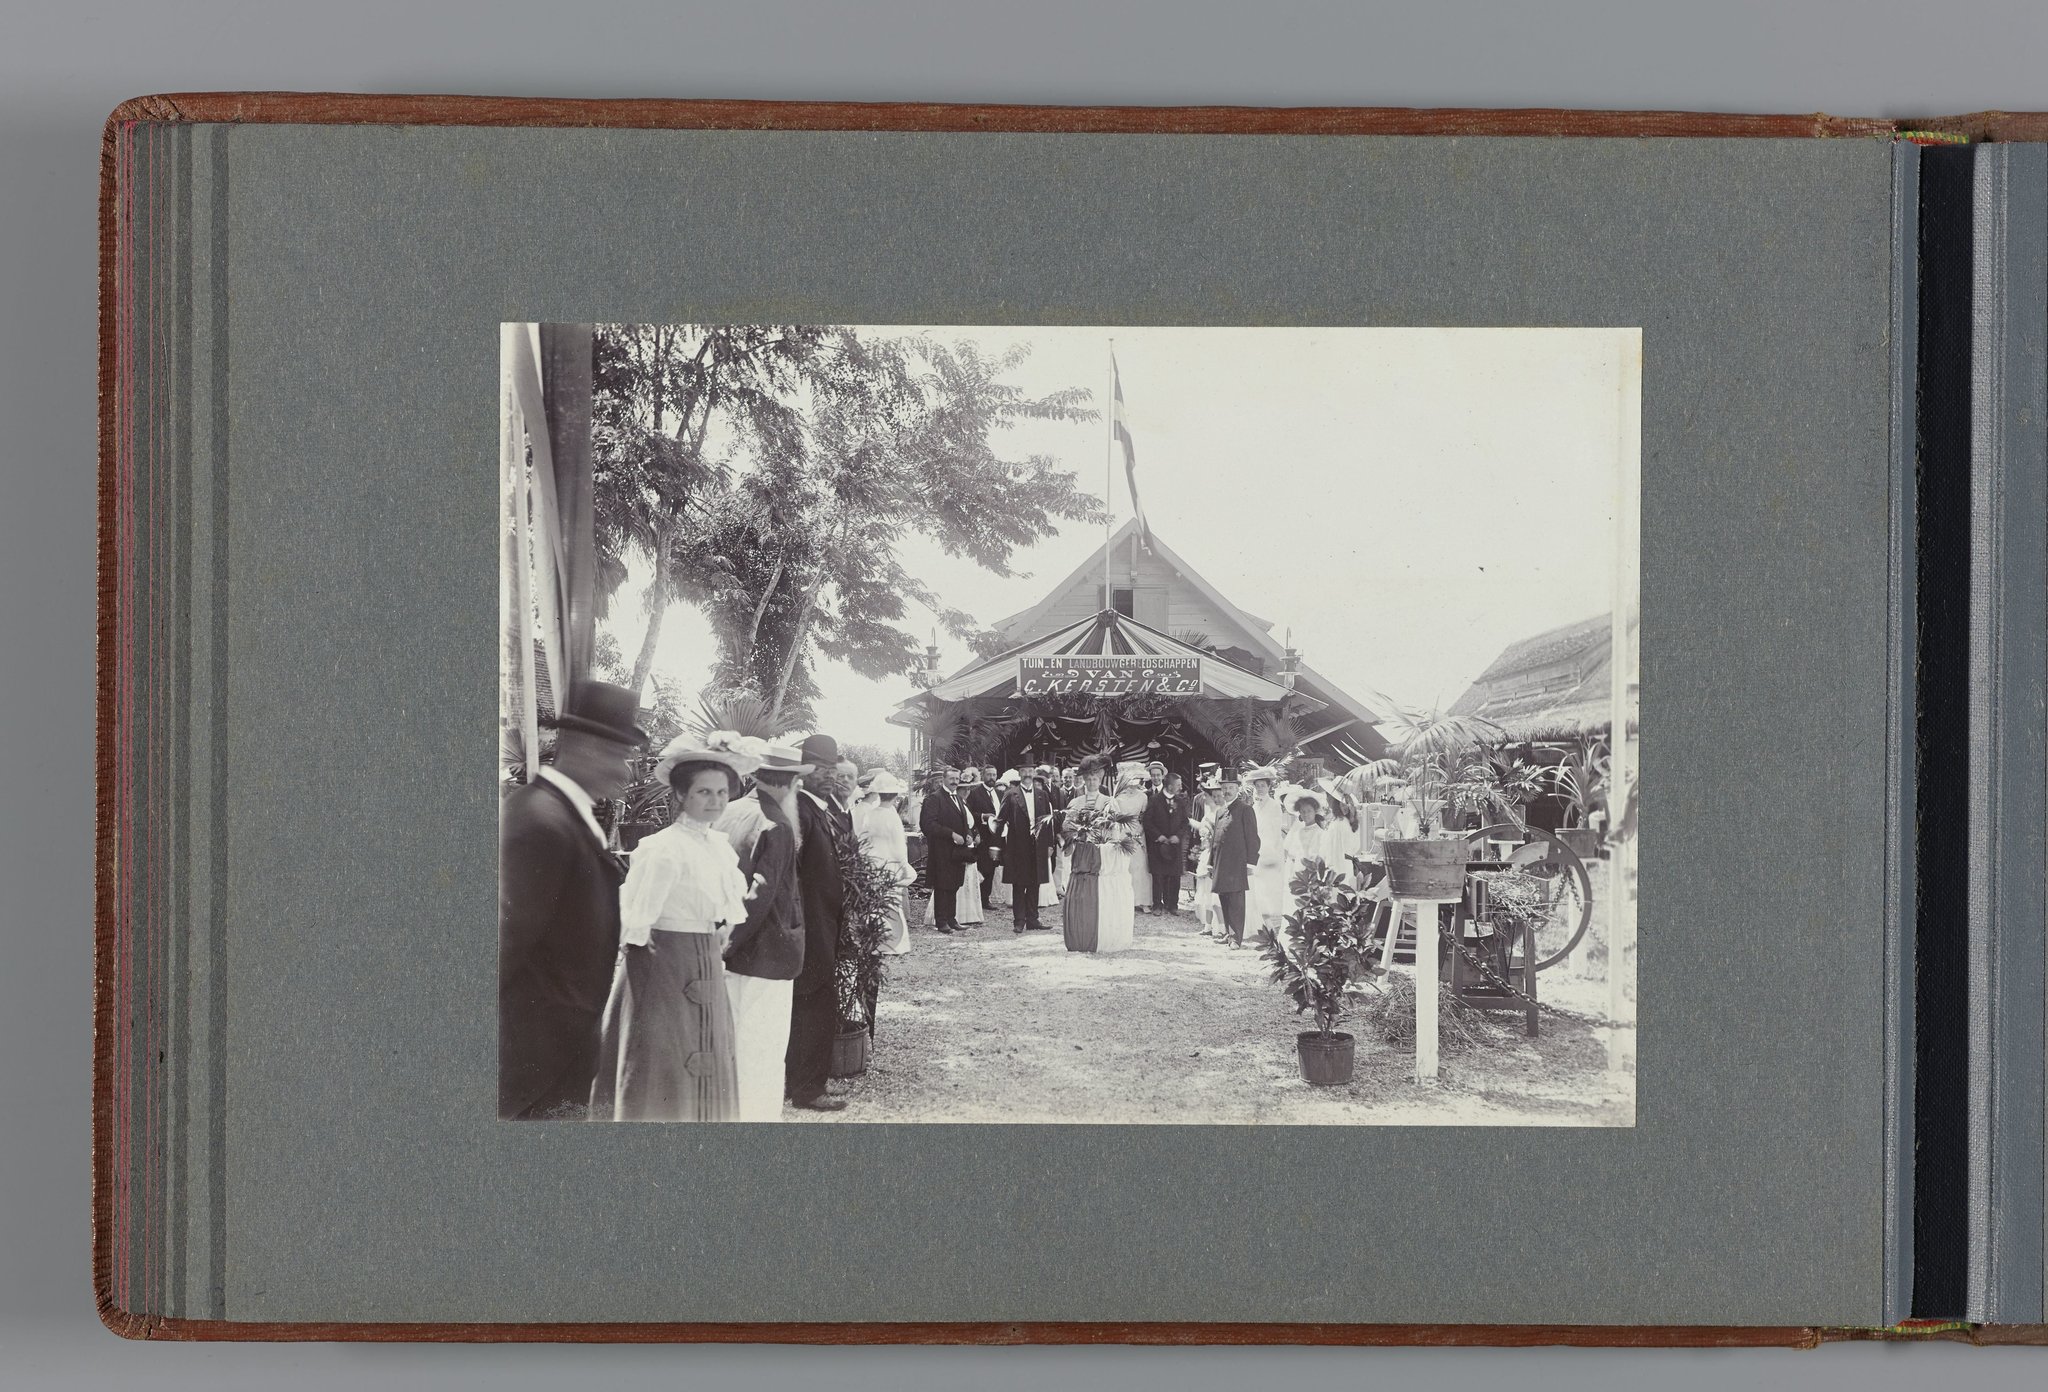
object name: photograph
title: Bezoek aan een landbouwtentoonstelling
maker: Anonymous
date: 1905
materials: cardboard, paper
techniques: photography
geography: paramaribo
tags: (annual) fair, trade fair, suriname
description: Gezelschap staand voor een tent waarop een bord hangt met de tekst: Tuin- en landbouwgereedschappen van C. Kersten & Co. Onderdeel van fotoalbum 'Suriname'.